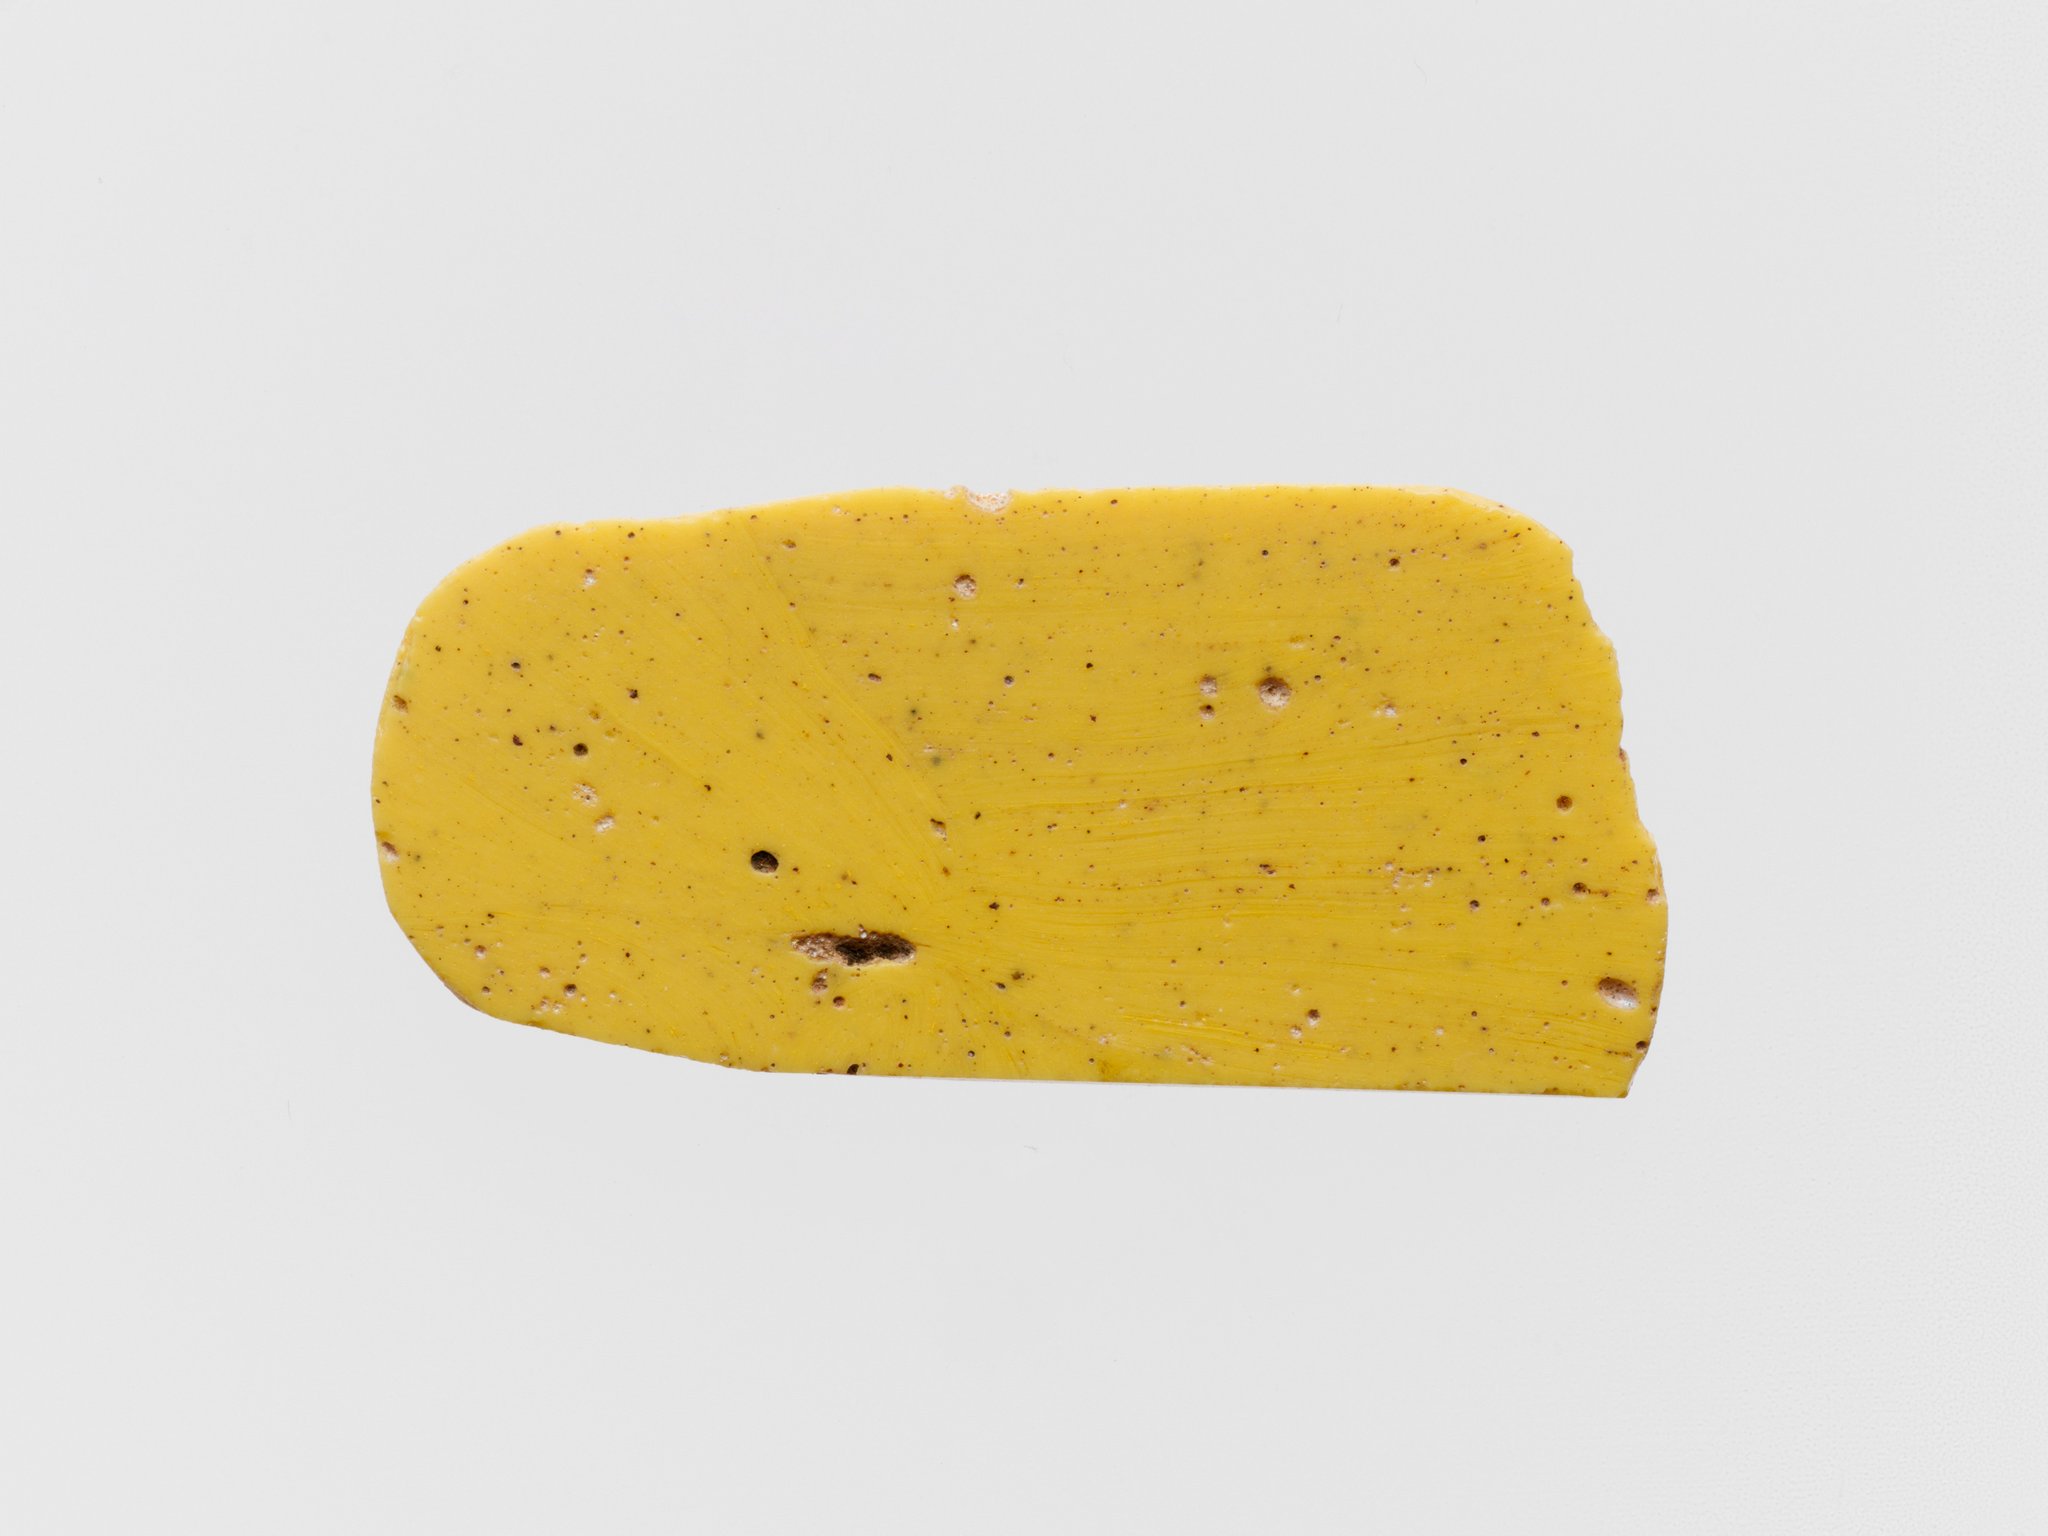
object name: fragment, monochrome inlay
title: Glass monochrome inlay fragment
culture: roman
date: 34 BCE-33 CE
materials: glass